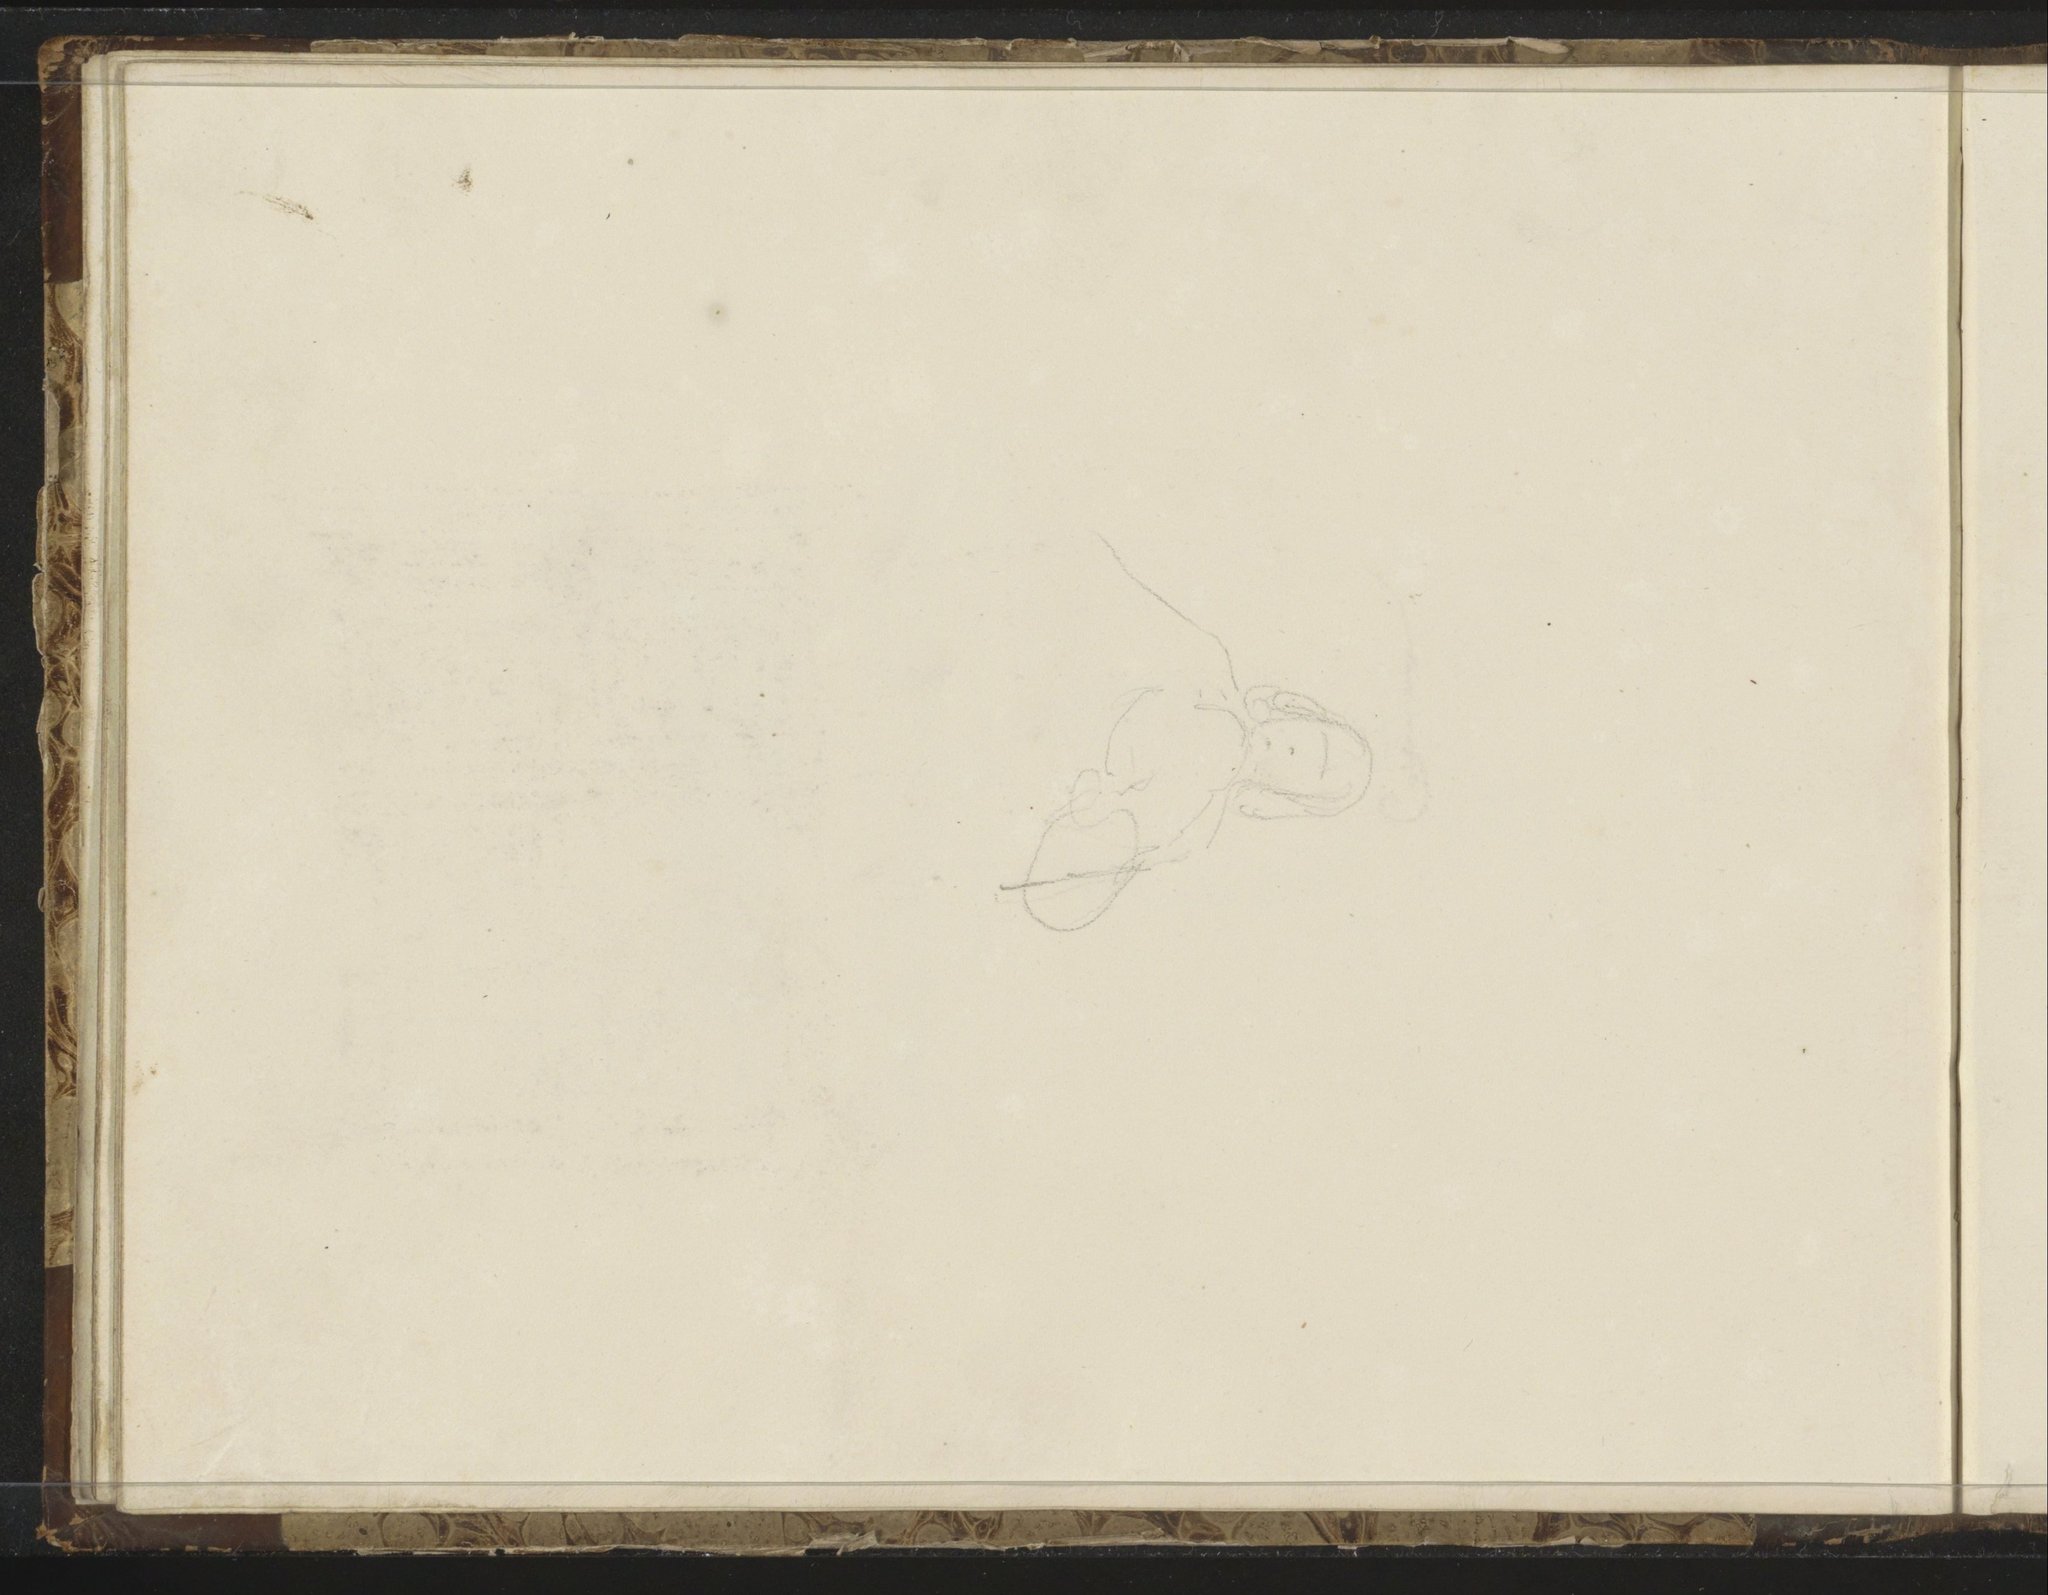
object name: sketchbook leaf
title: Hoofd en schouders van een man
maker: willem hendrik schmidt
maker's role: draughtsman, painter, print maker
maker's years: 1809-1849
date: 1819-1849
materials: paper, pencil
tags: head (human)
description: De man houdt mogelijk een schilderspalet vast. Blad 11 verso uit een schetsboek met 52 bladen.